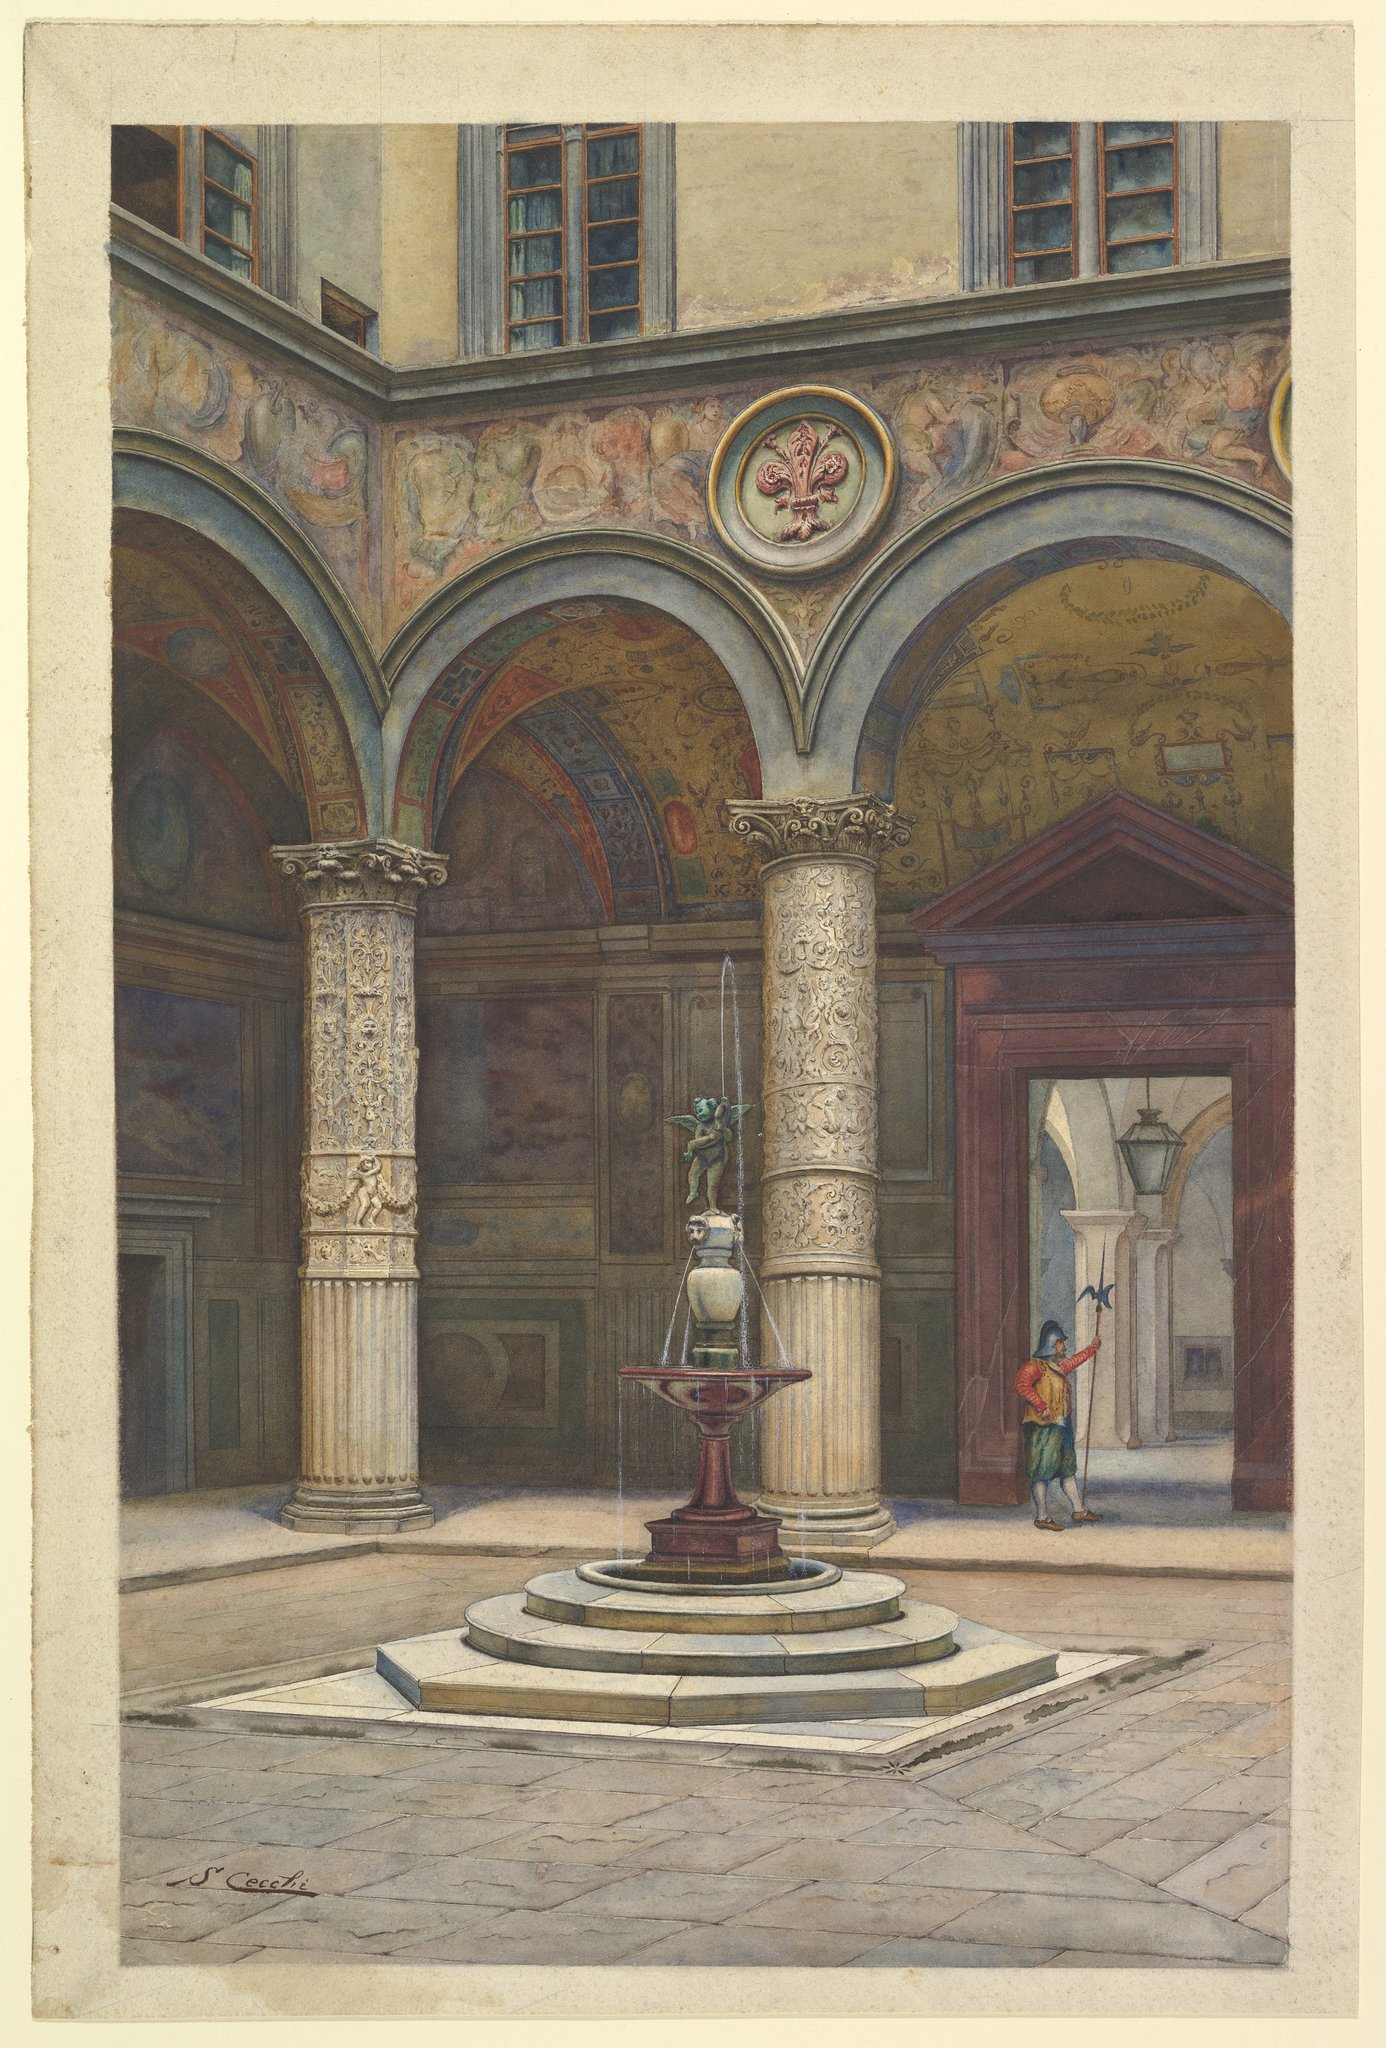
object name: drawing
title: Courtyard of the Palazzo Vecchio, Florence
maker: s. cecchi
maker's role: artist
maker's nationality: italian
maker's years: 1800-1900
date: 1801-1900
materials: watercolor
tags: fountains,courtyards